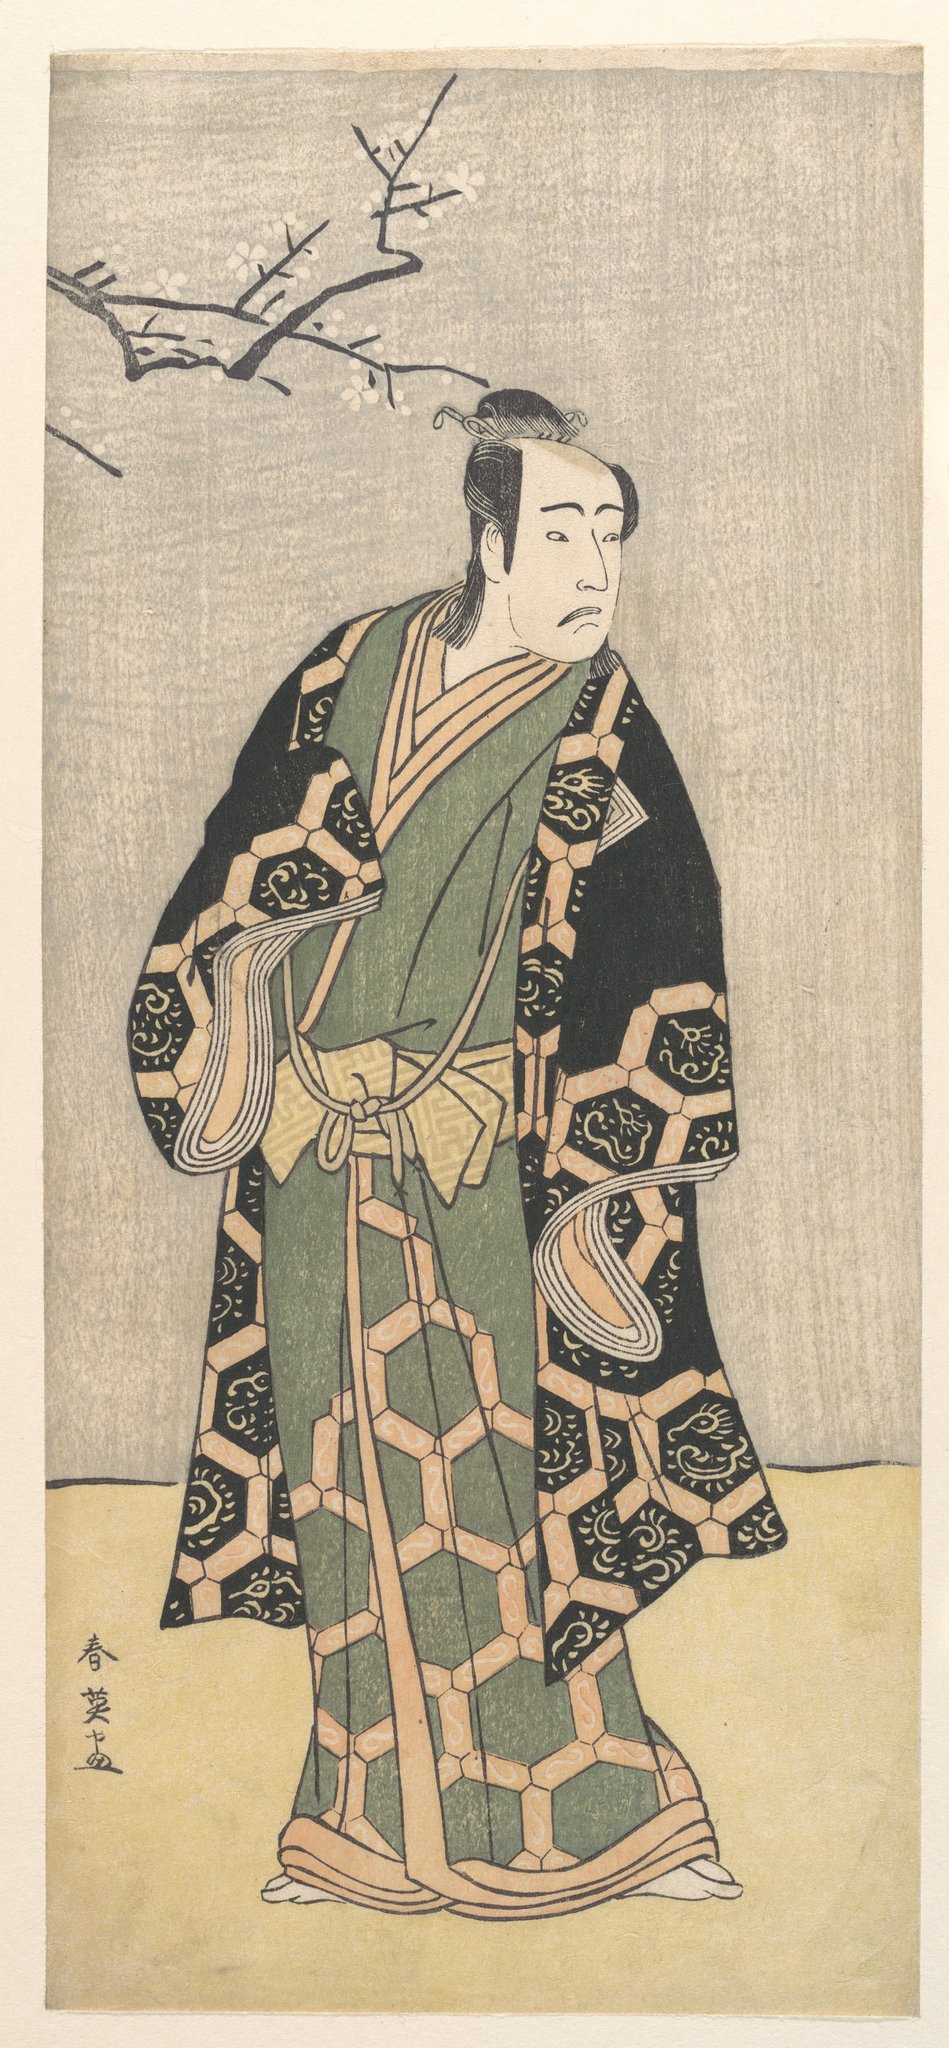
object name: print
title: An Unidentified Actor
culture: japanese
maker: katsukawa shun'ei 勝川春英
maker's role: artist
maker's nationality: japanese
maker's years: 1762-1819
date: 1762-1819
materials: ink, paper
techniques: woodblock print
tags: men,actors